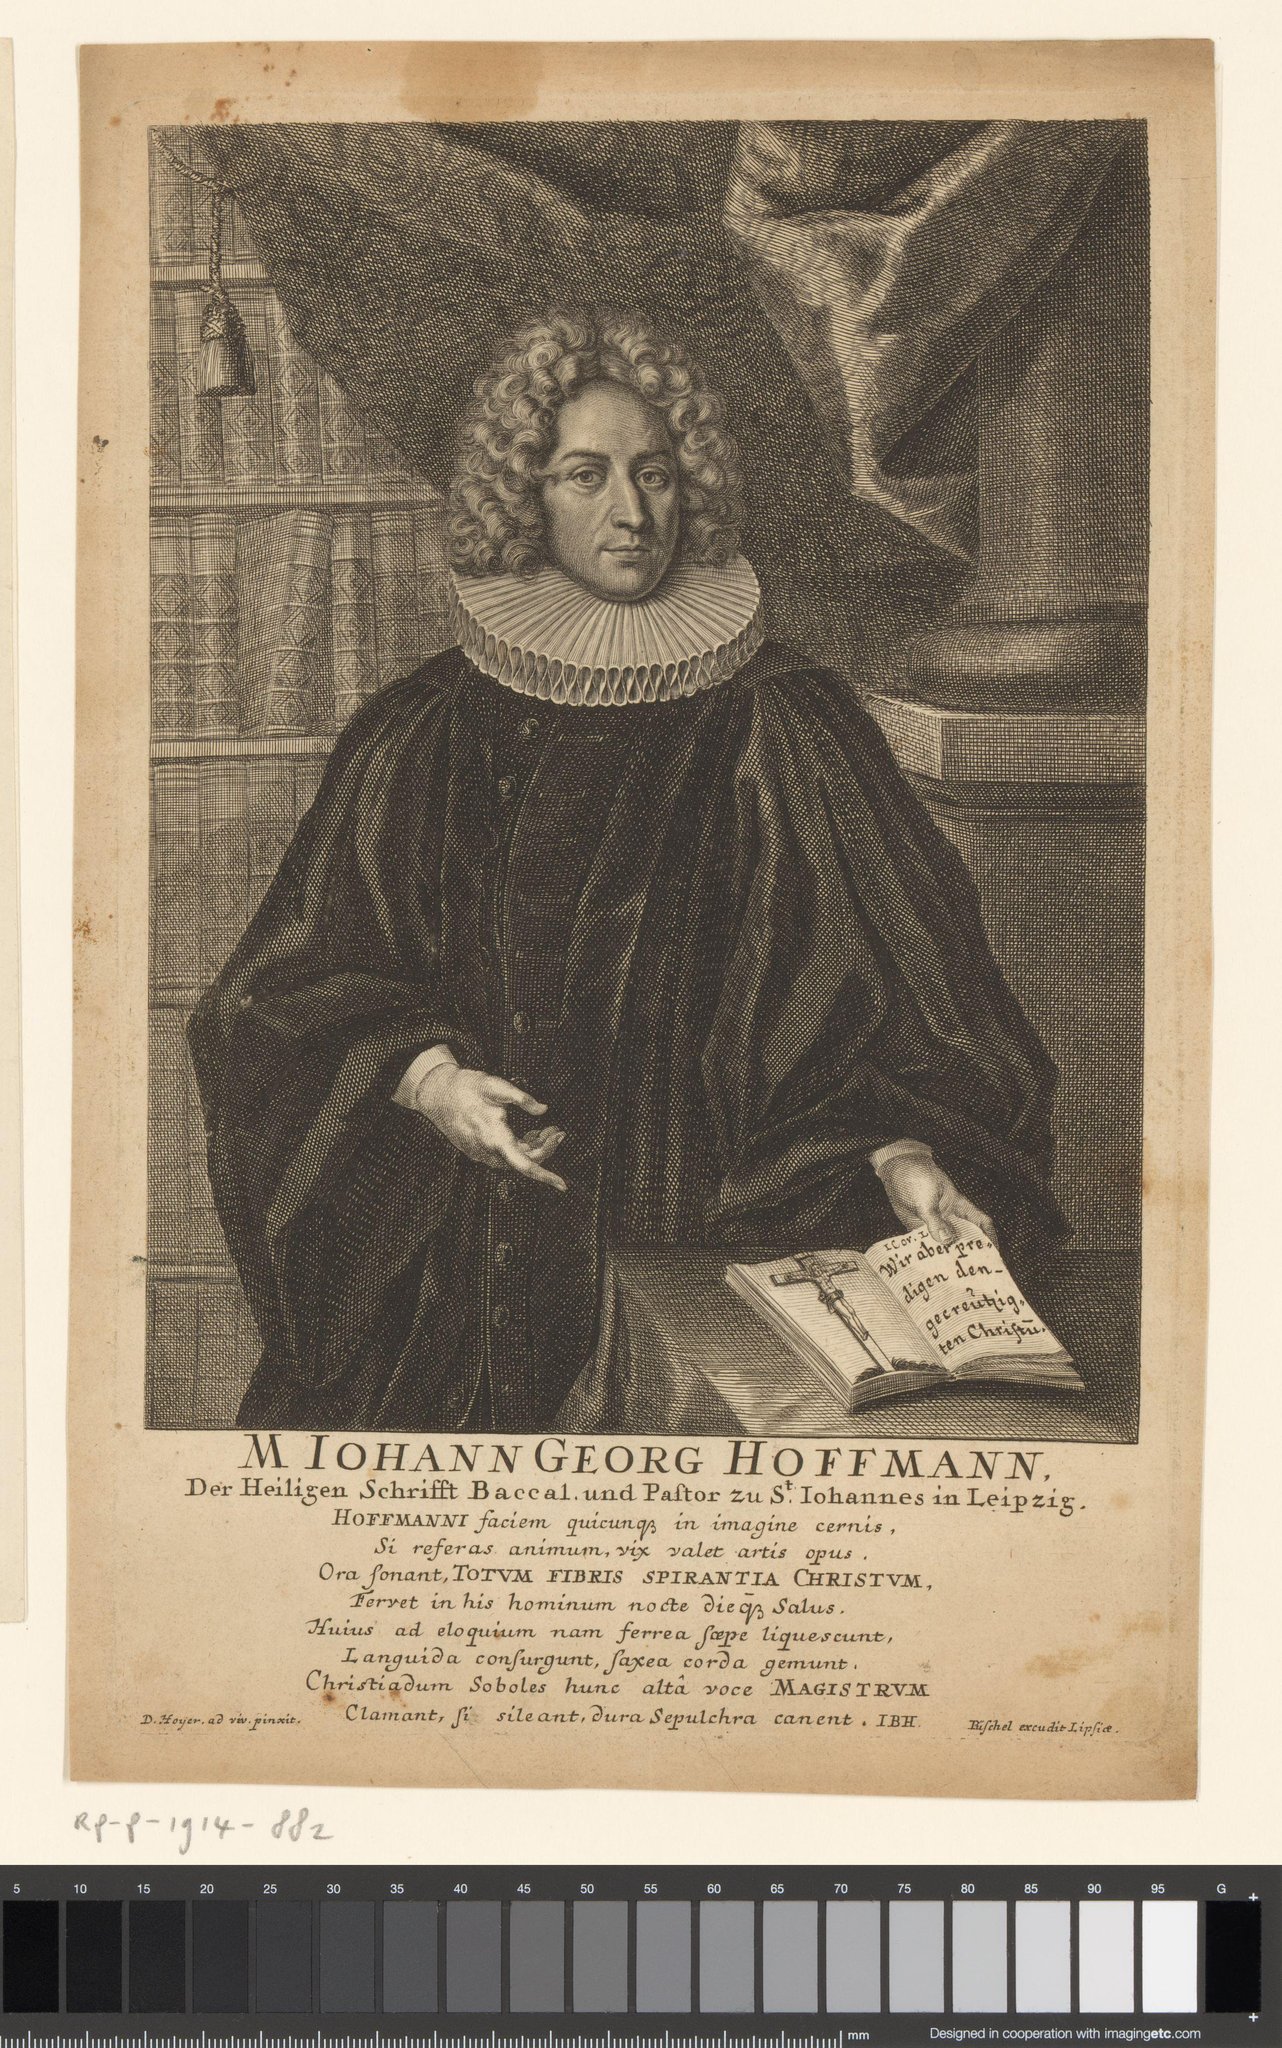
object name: print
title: Portret van Johann Georg Hoffmann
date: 1700-1720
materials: paper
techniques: engraving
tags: bookshelves, historical persons, book, crucifix ~ personal devotion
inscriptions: collector's mark: Lugt 2228